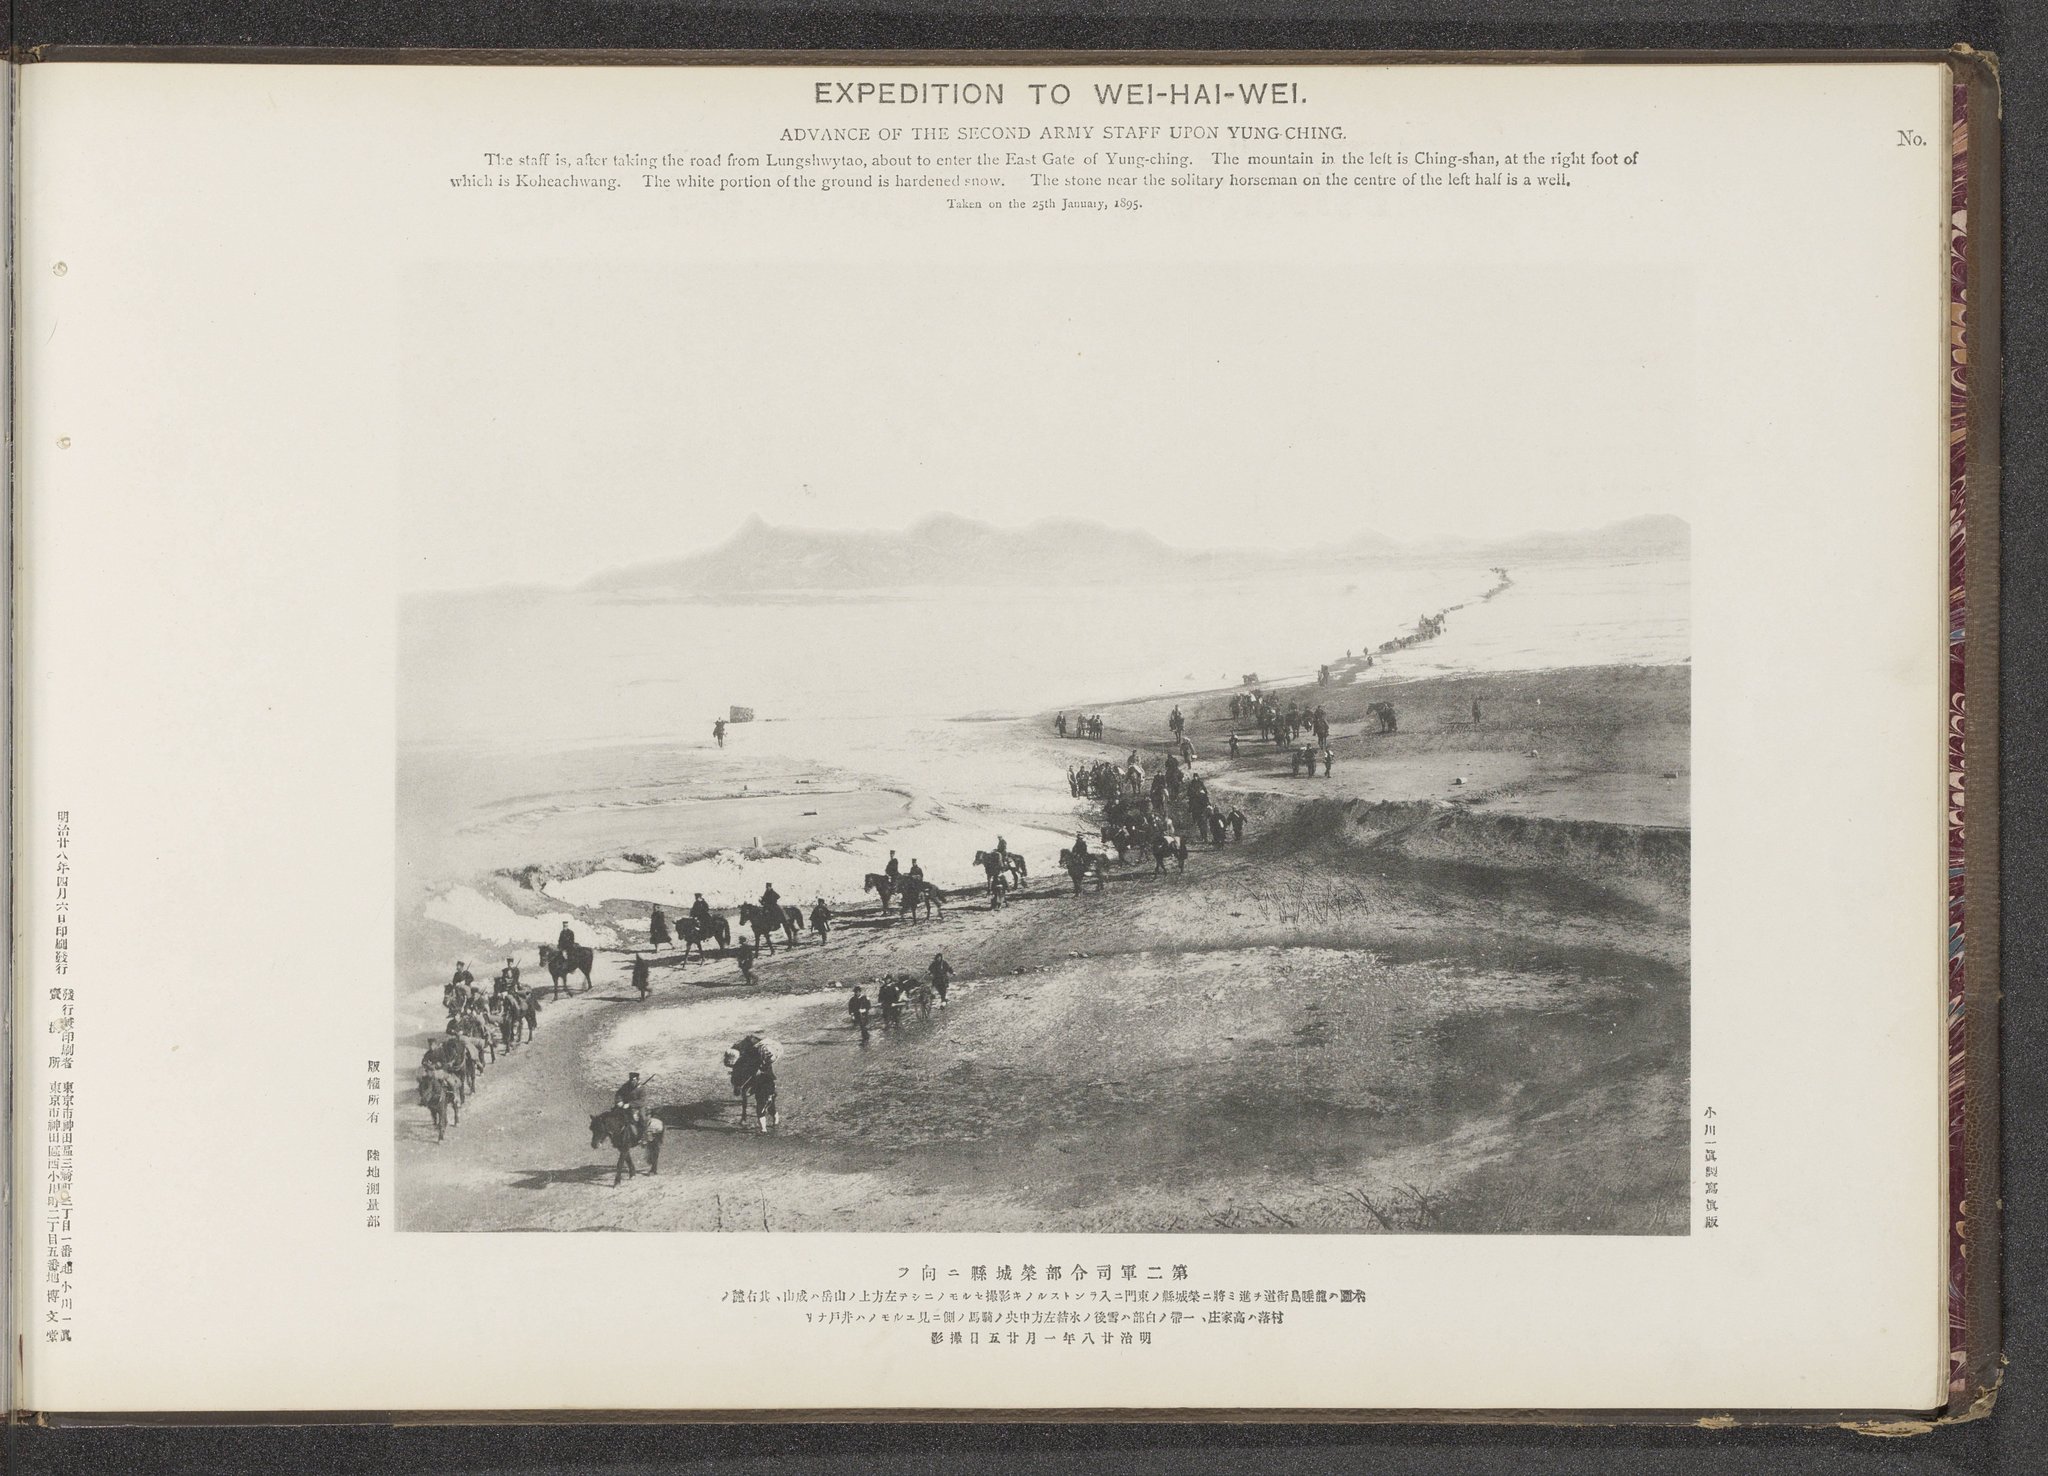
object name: page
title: Advance of the second army staff upon Yung Ching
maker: kazumasa ogawa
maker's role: auteur, fotograaf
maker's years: 1860-1929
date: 1895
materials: paper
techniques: photograph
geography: china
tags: army 'en route'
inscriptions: inscription: ‘The staff is, after taking the road (...) The stone near the solitary horseman on the centre of the left half is a well.’, inscription: ‘Expedition to Wei-hai-wei.’